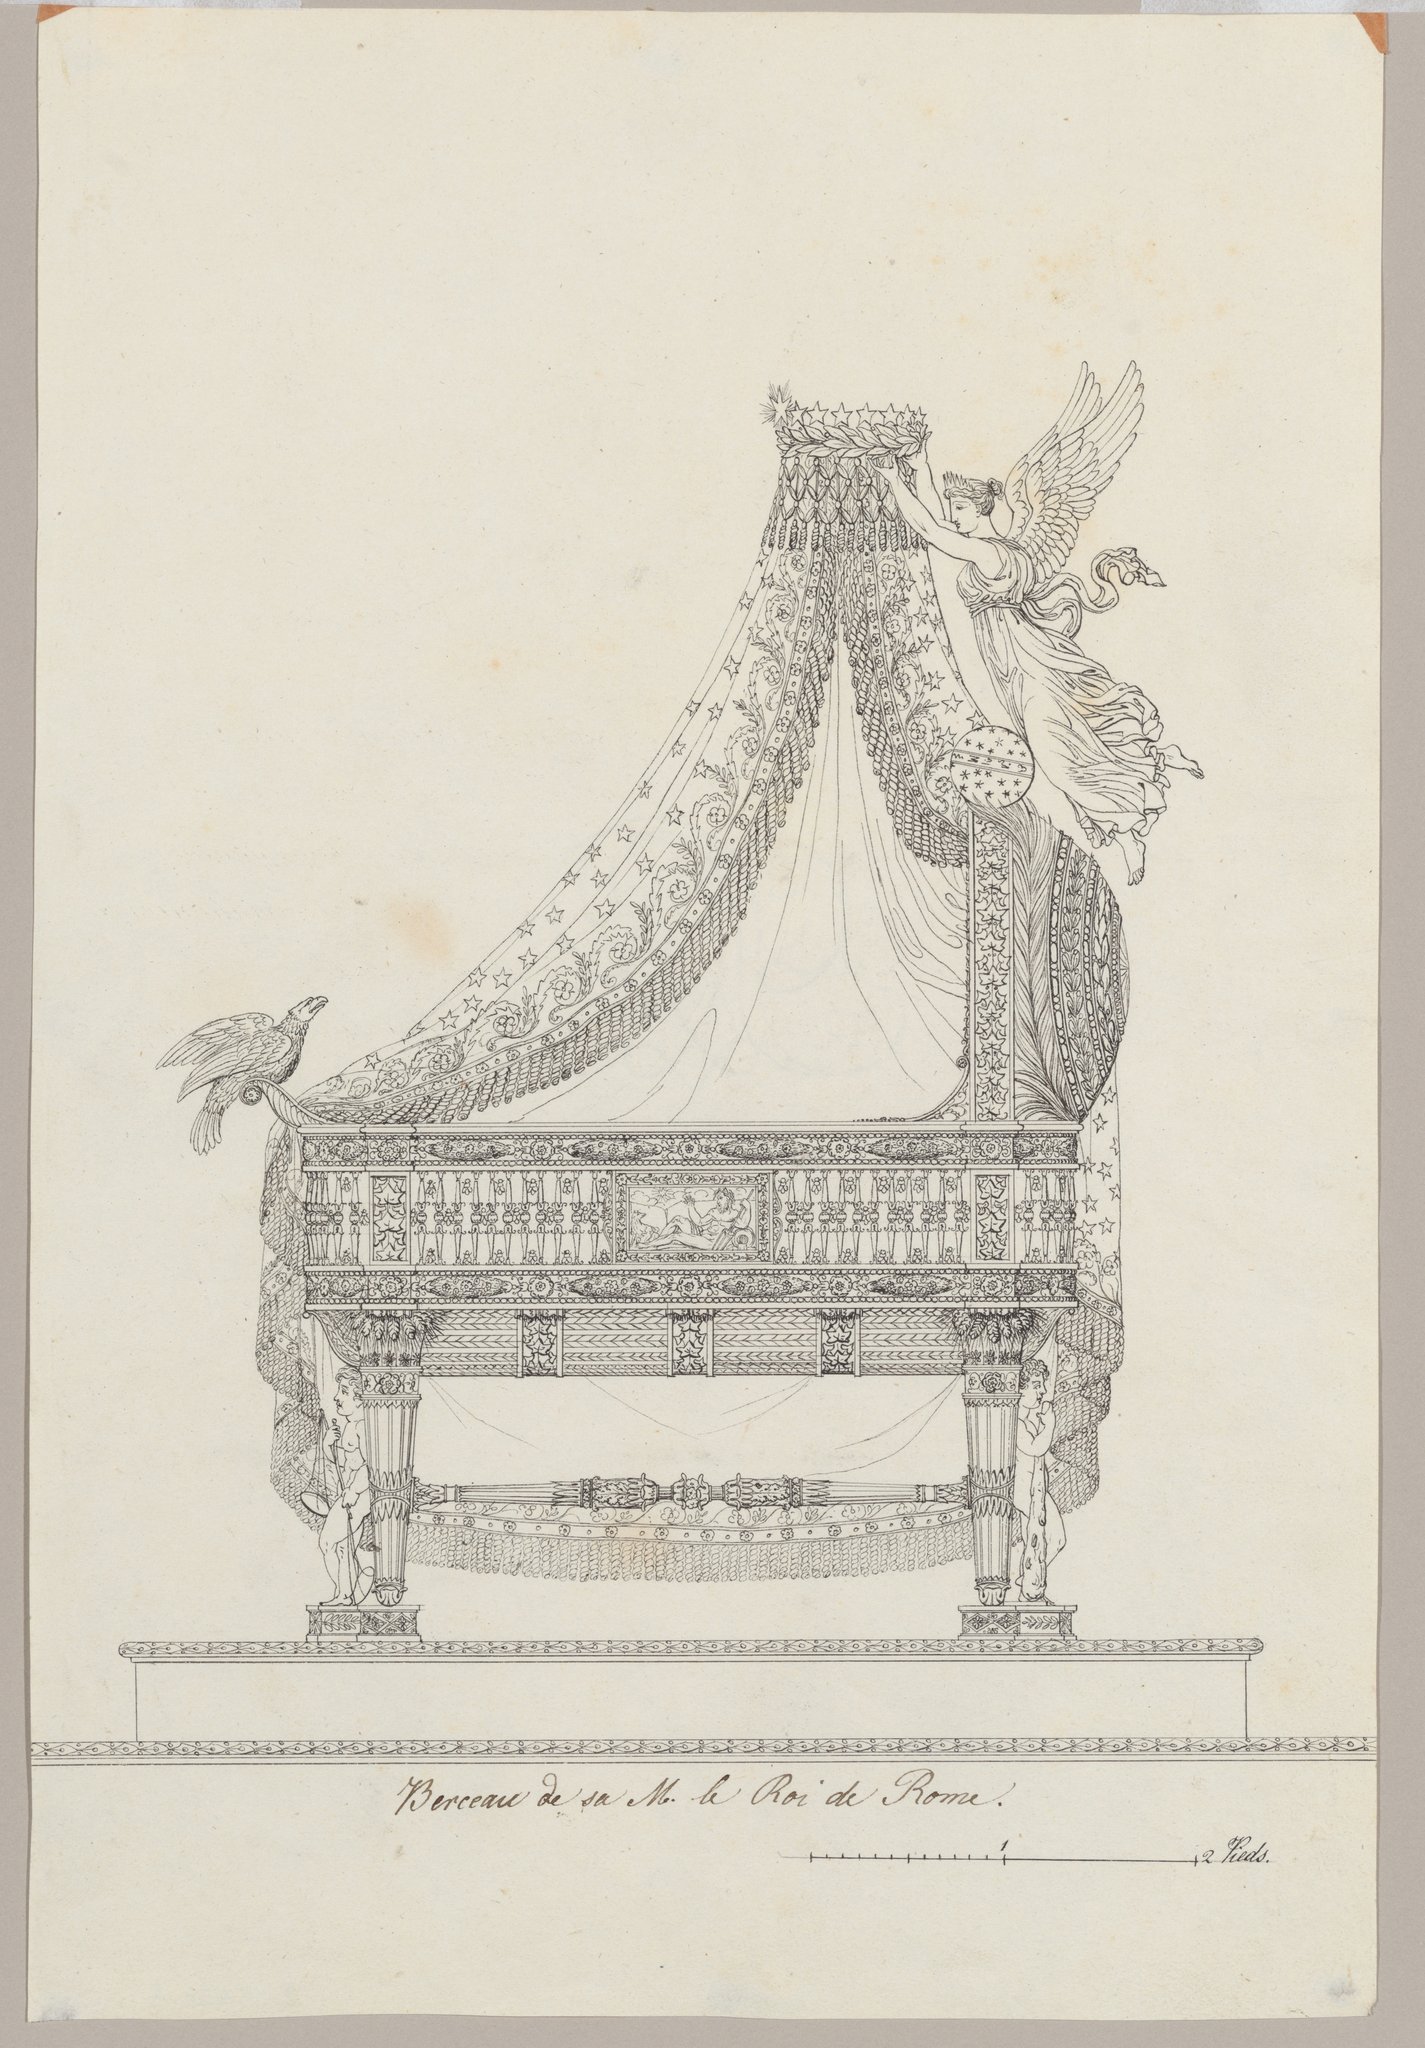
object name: print ornament architecture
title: Side View of The Cradle of His Majesty the King of Rome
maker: adrien louis marie cavelier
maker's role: artist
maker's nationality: french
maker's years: 1785-1867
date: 1810-1811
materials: ink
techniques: pen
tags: cradles